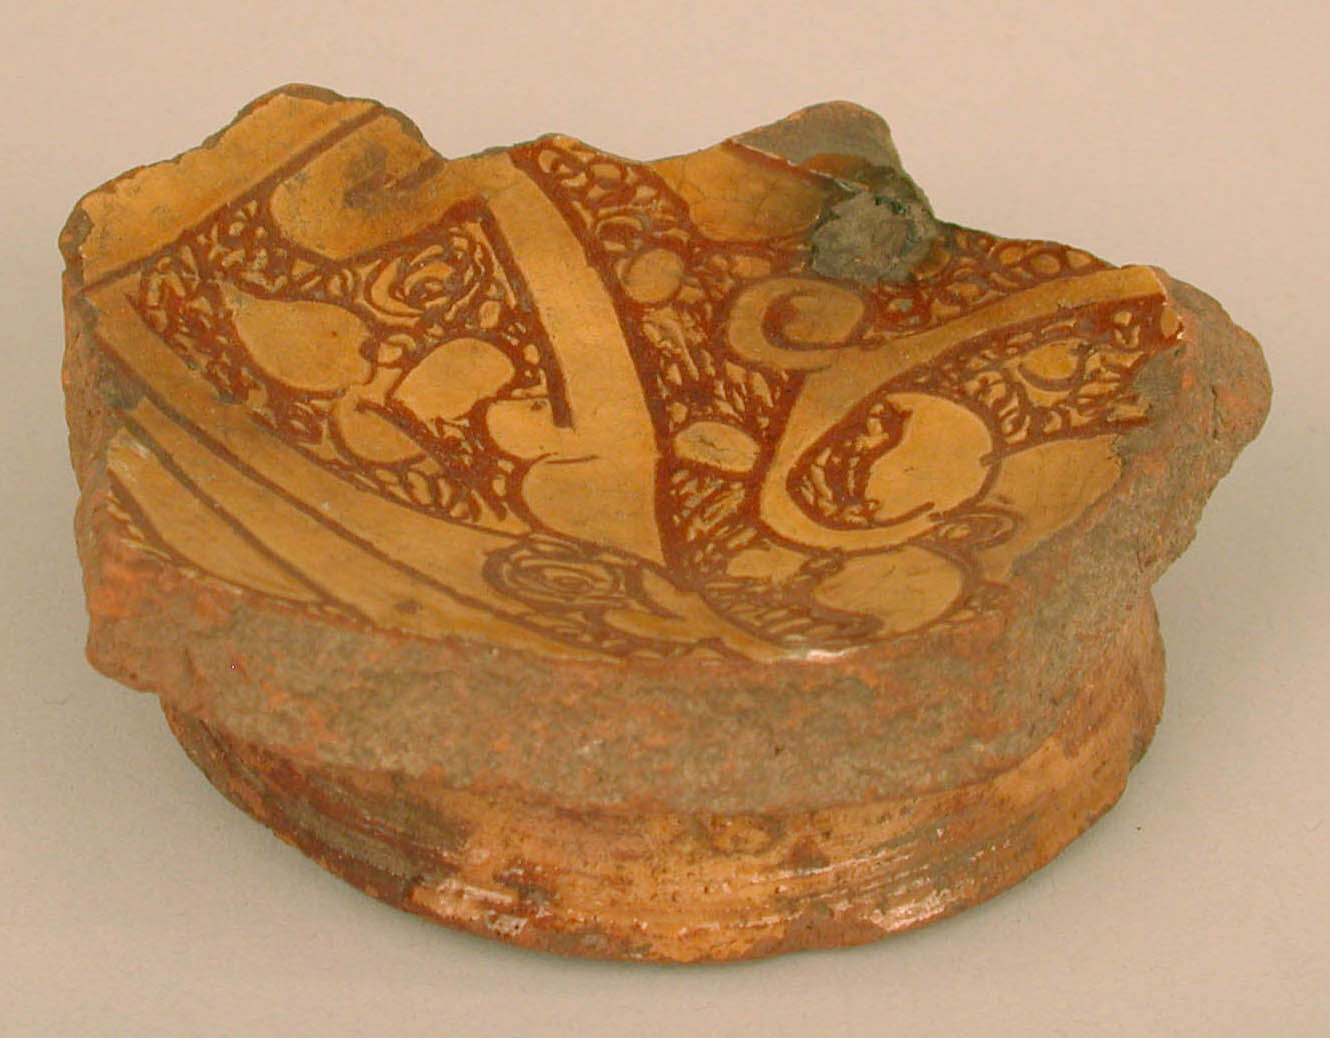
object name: ceramic fragment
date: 1301-1500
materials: earthenware, glaze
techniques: coloring, incising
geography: egypt